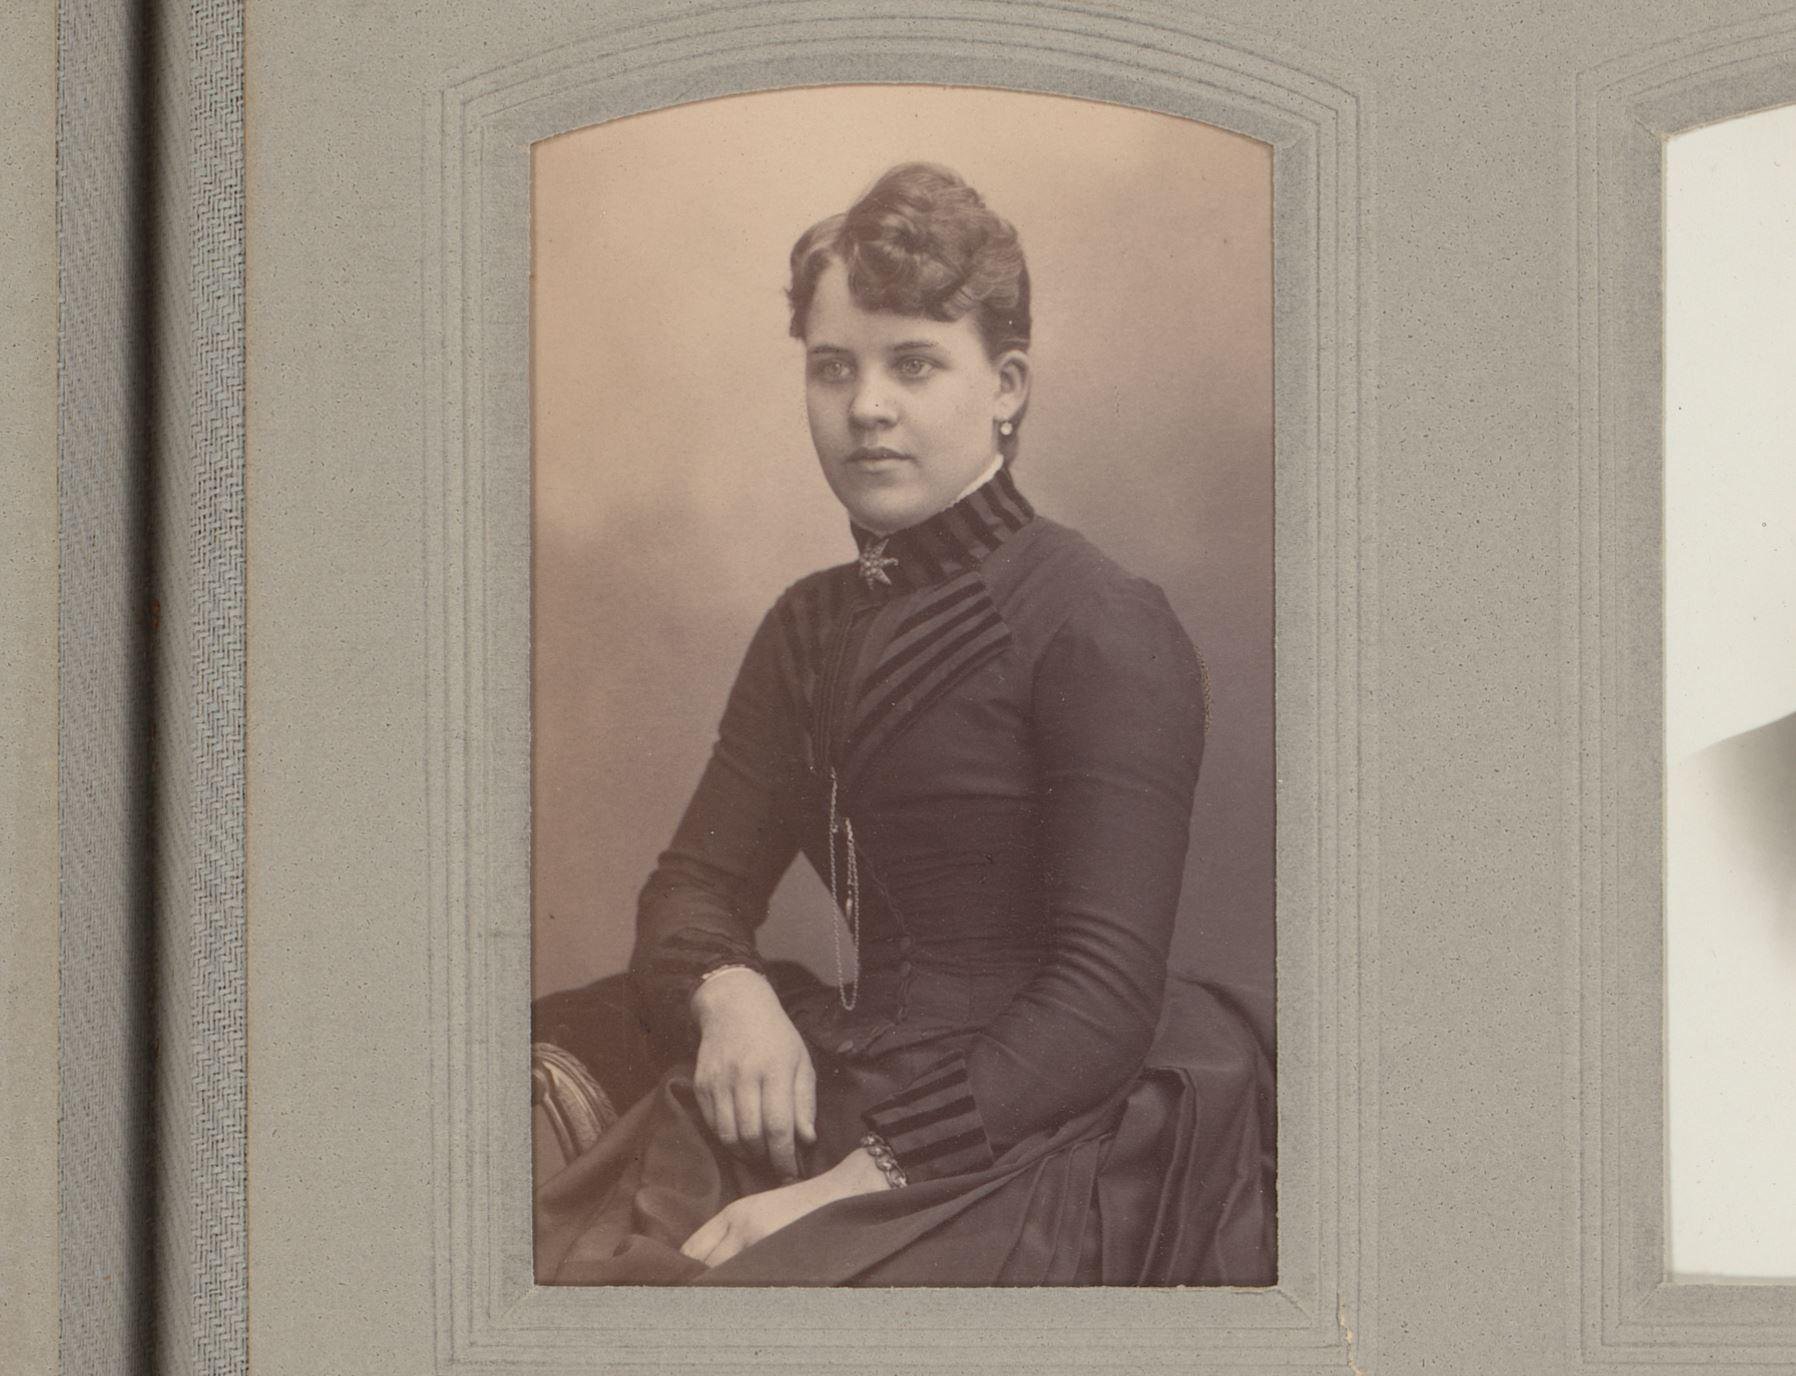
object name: photograph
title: Portret van een zittende vrouw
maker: oscar json runstedt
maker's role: fotograaf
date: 1860-1900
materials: cardboard, photographic support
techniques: albumen print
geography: stockholm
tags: sitting figure - aa - female human figure, historical persons - bb - woman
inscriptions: inscription: ‘Oscar Json Runstedt/ Stockholm/ 15 Brunkebergstorg/ Plåten förvaras för efterbeställning.’